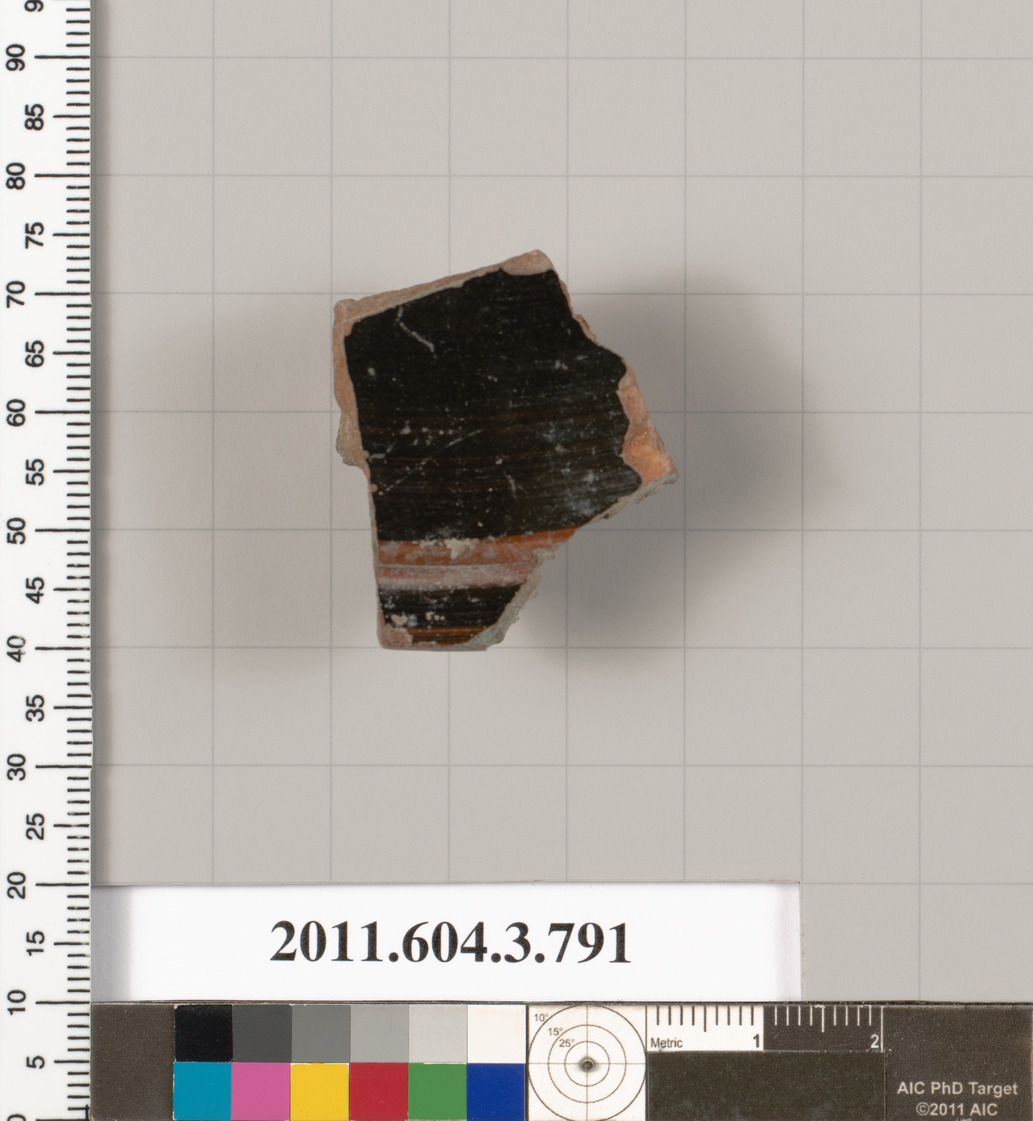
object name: lid fragment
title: Terracotta fragment of a lid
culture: greek, attic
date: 600-501 BCE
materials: terracotta